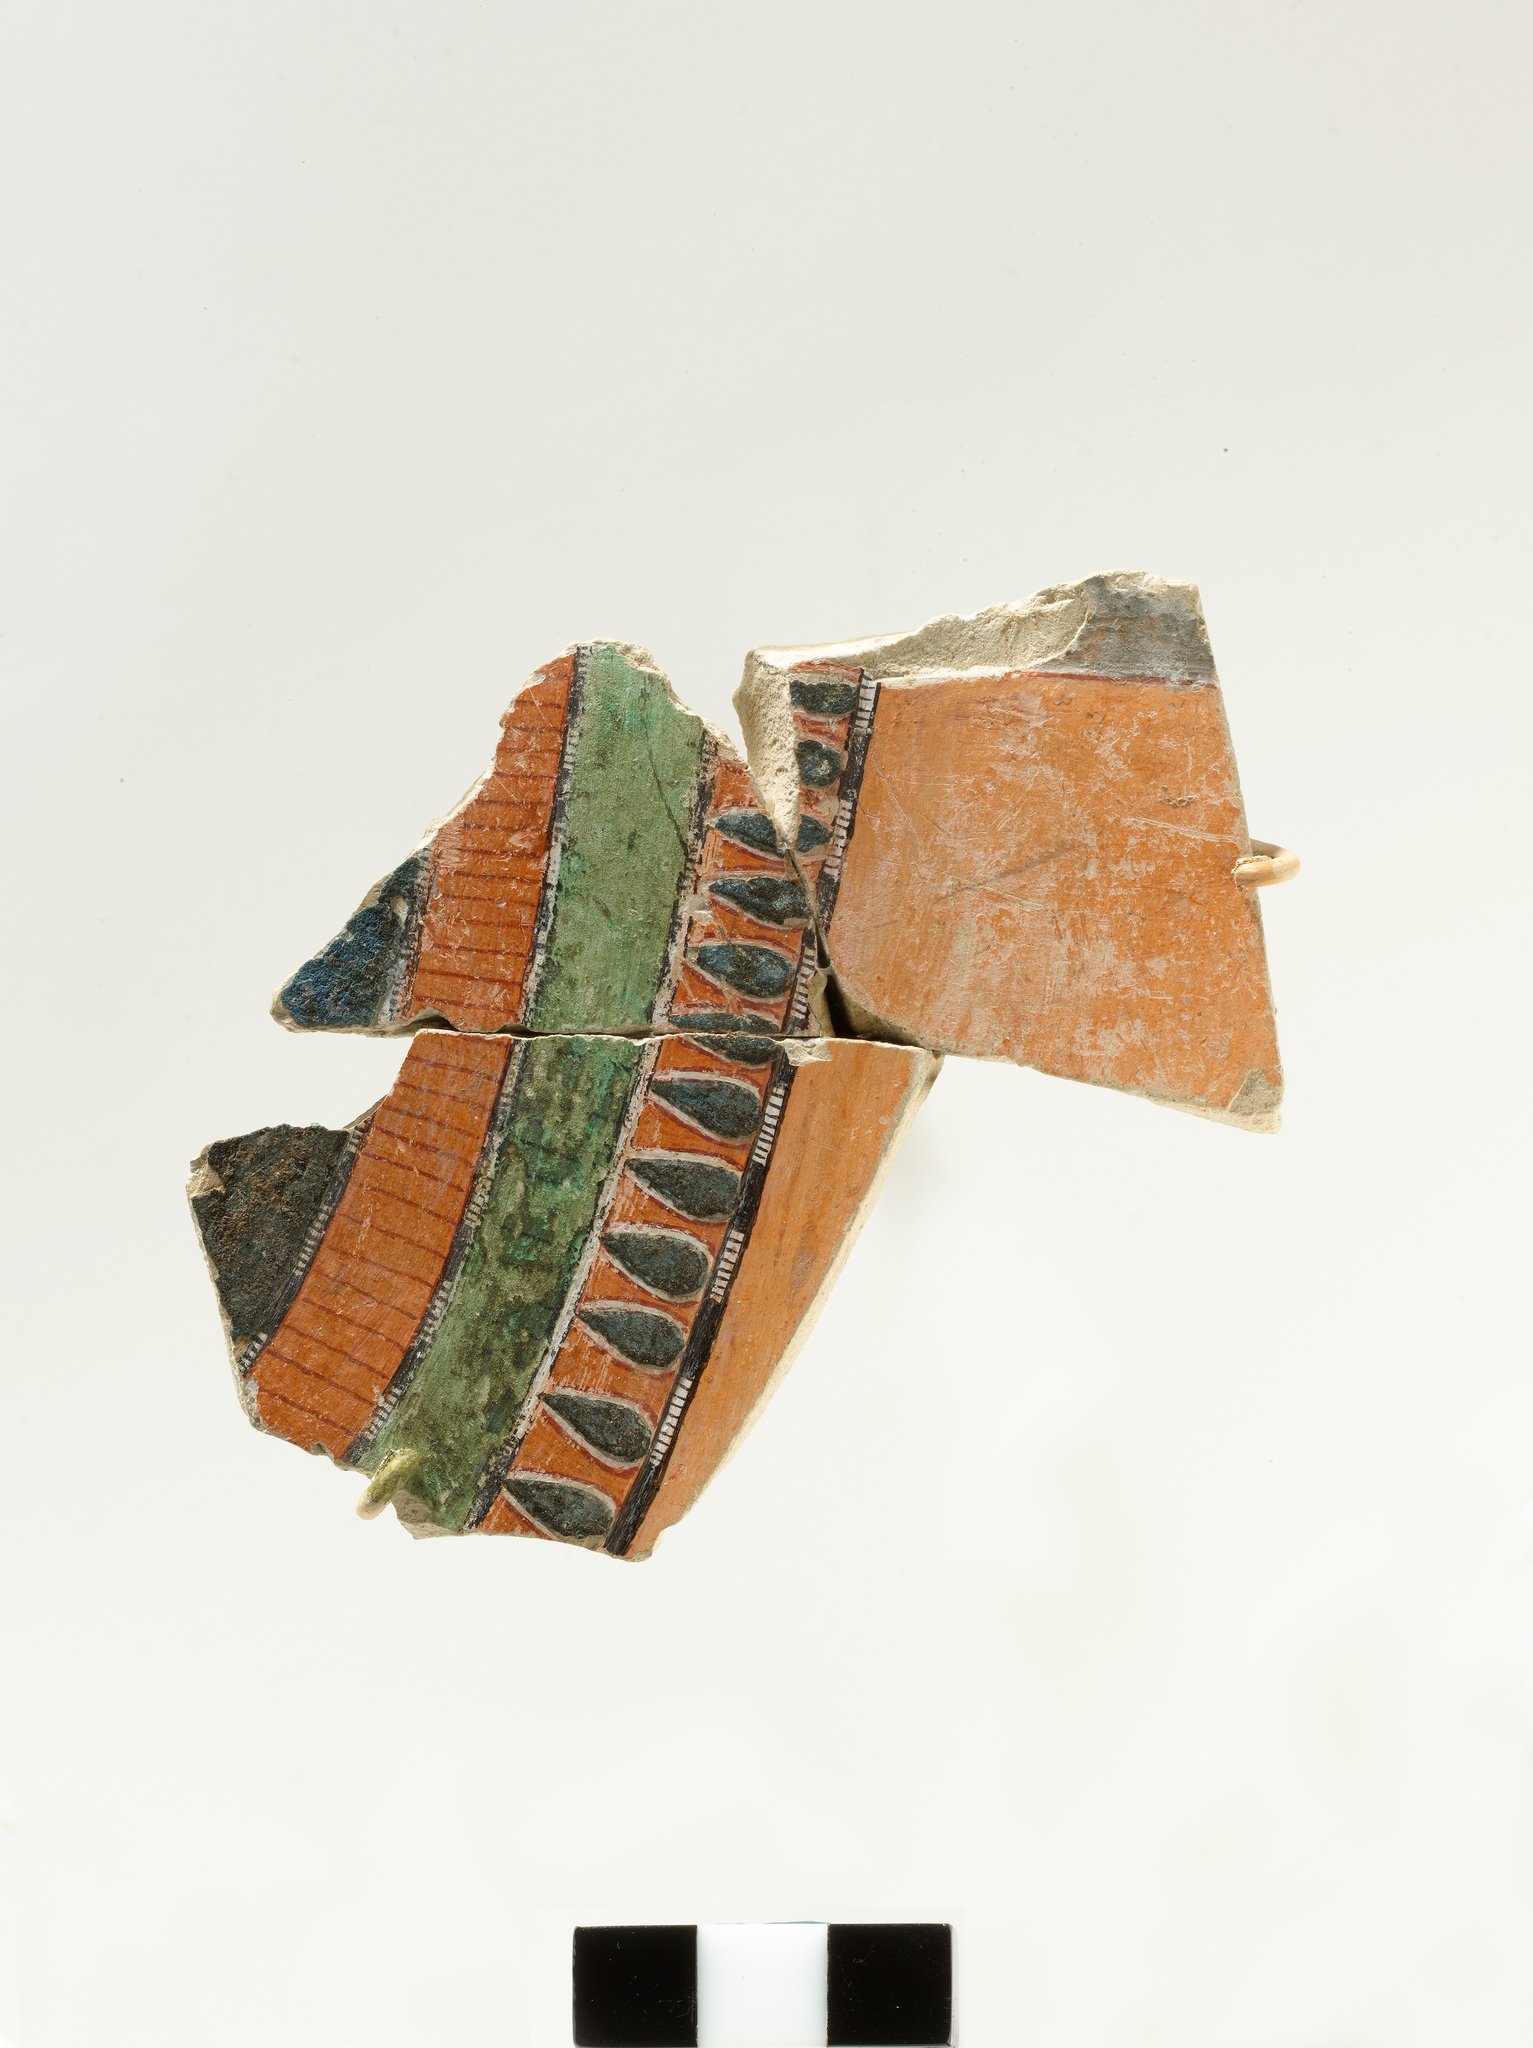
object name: relief fragment, tomb of meketre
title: Reliefs from the tomb of Meketre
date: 1981-1975 BCE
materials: limestone, paint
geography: egypt